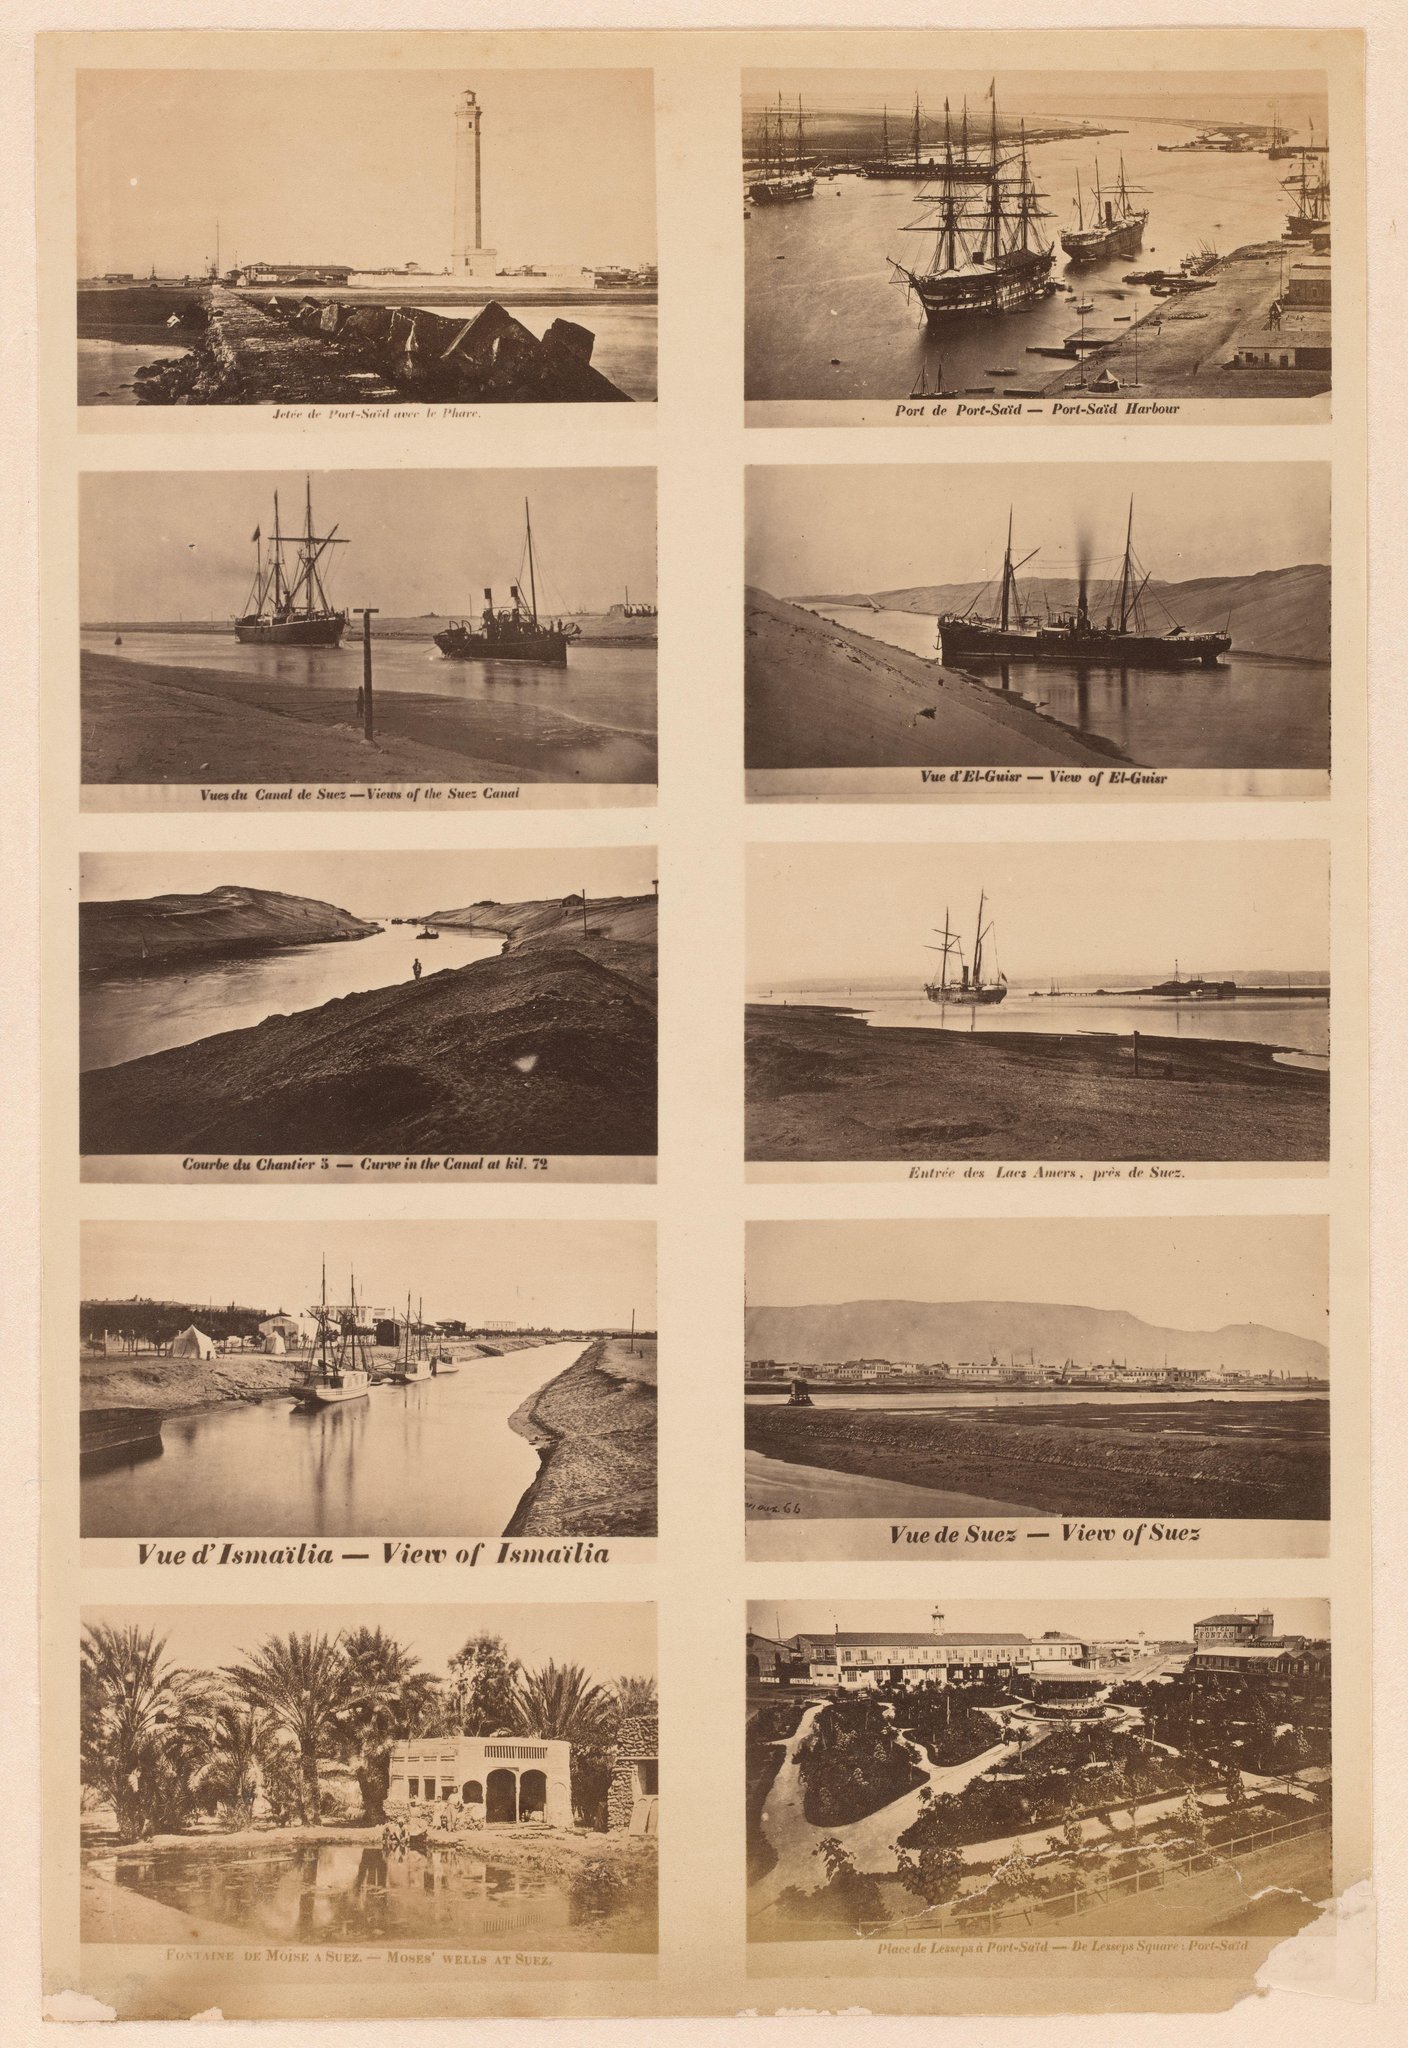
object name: photograph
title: Foto met tien reproducties van schepen in het Suezkanaal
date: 1869-1875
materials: paper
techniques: albumen print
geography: suez canal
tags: suezkanaal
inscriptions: number: ‘20’, number: ‘R14/7 [doorgestrepen]’, inscription: ‘Suez’, signature: ‘A.J.B.’, number: ‘BD. 124 [doorgestrepen]’